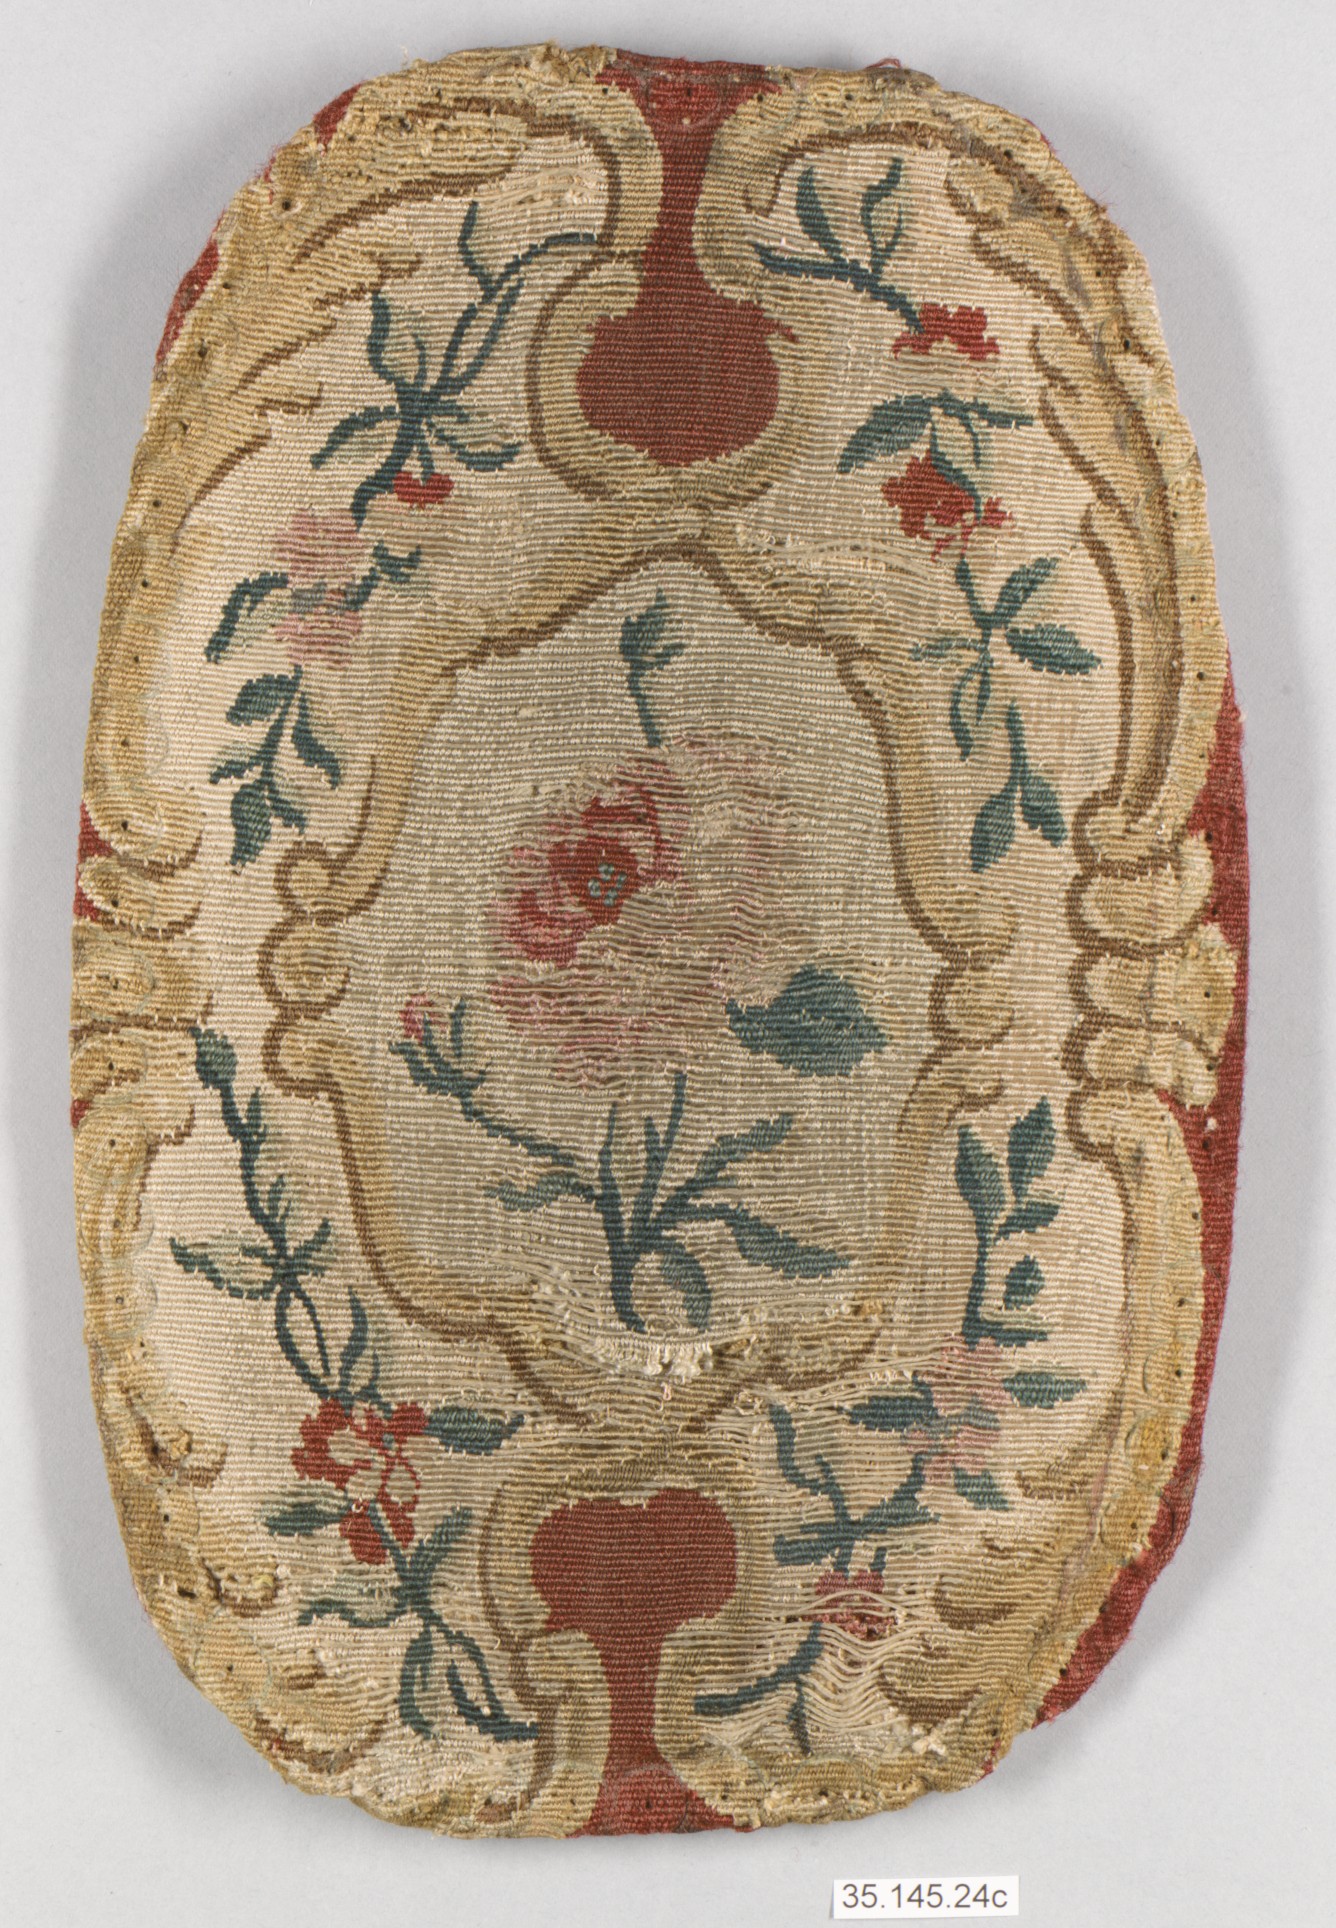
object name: upholstery panel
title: Four upholstery panels for an armchair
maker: beauvais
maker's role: manufactory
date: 1754-1756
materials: silk, wool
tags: flowers,leaves